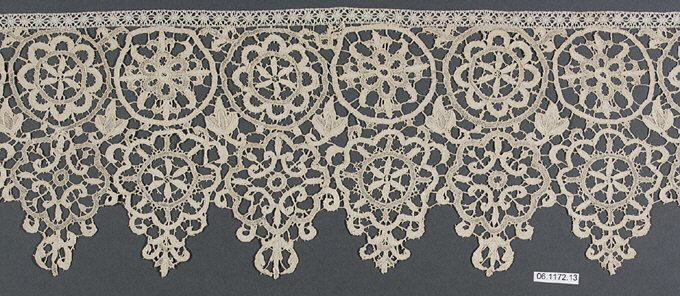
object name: pointed lace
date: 1601-1700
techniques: lace